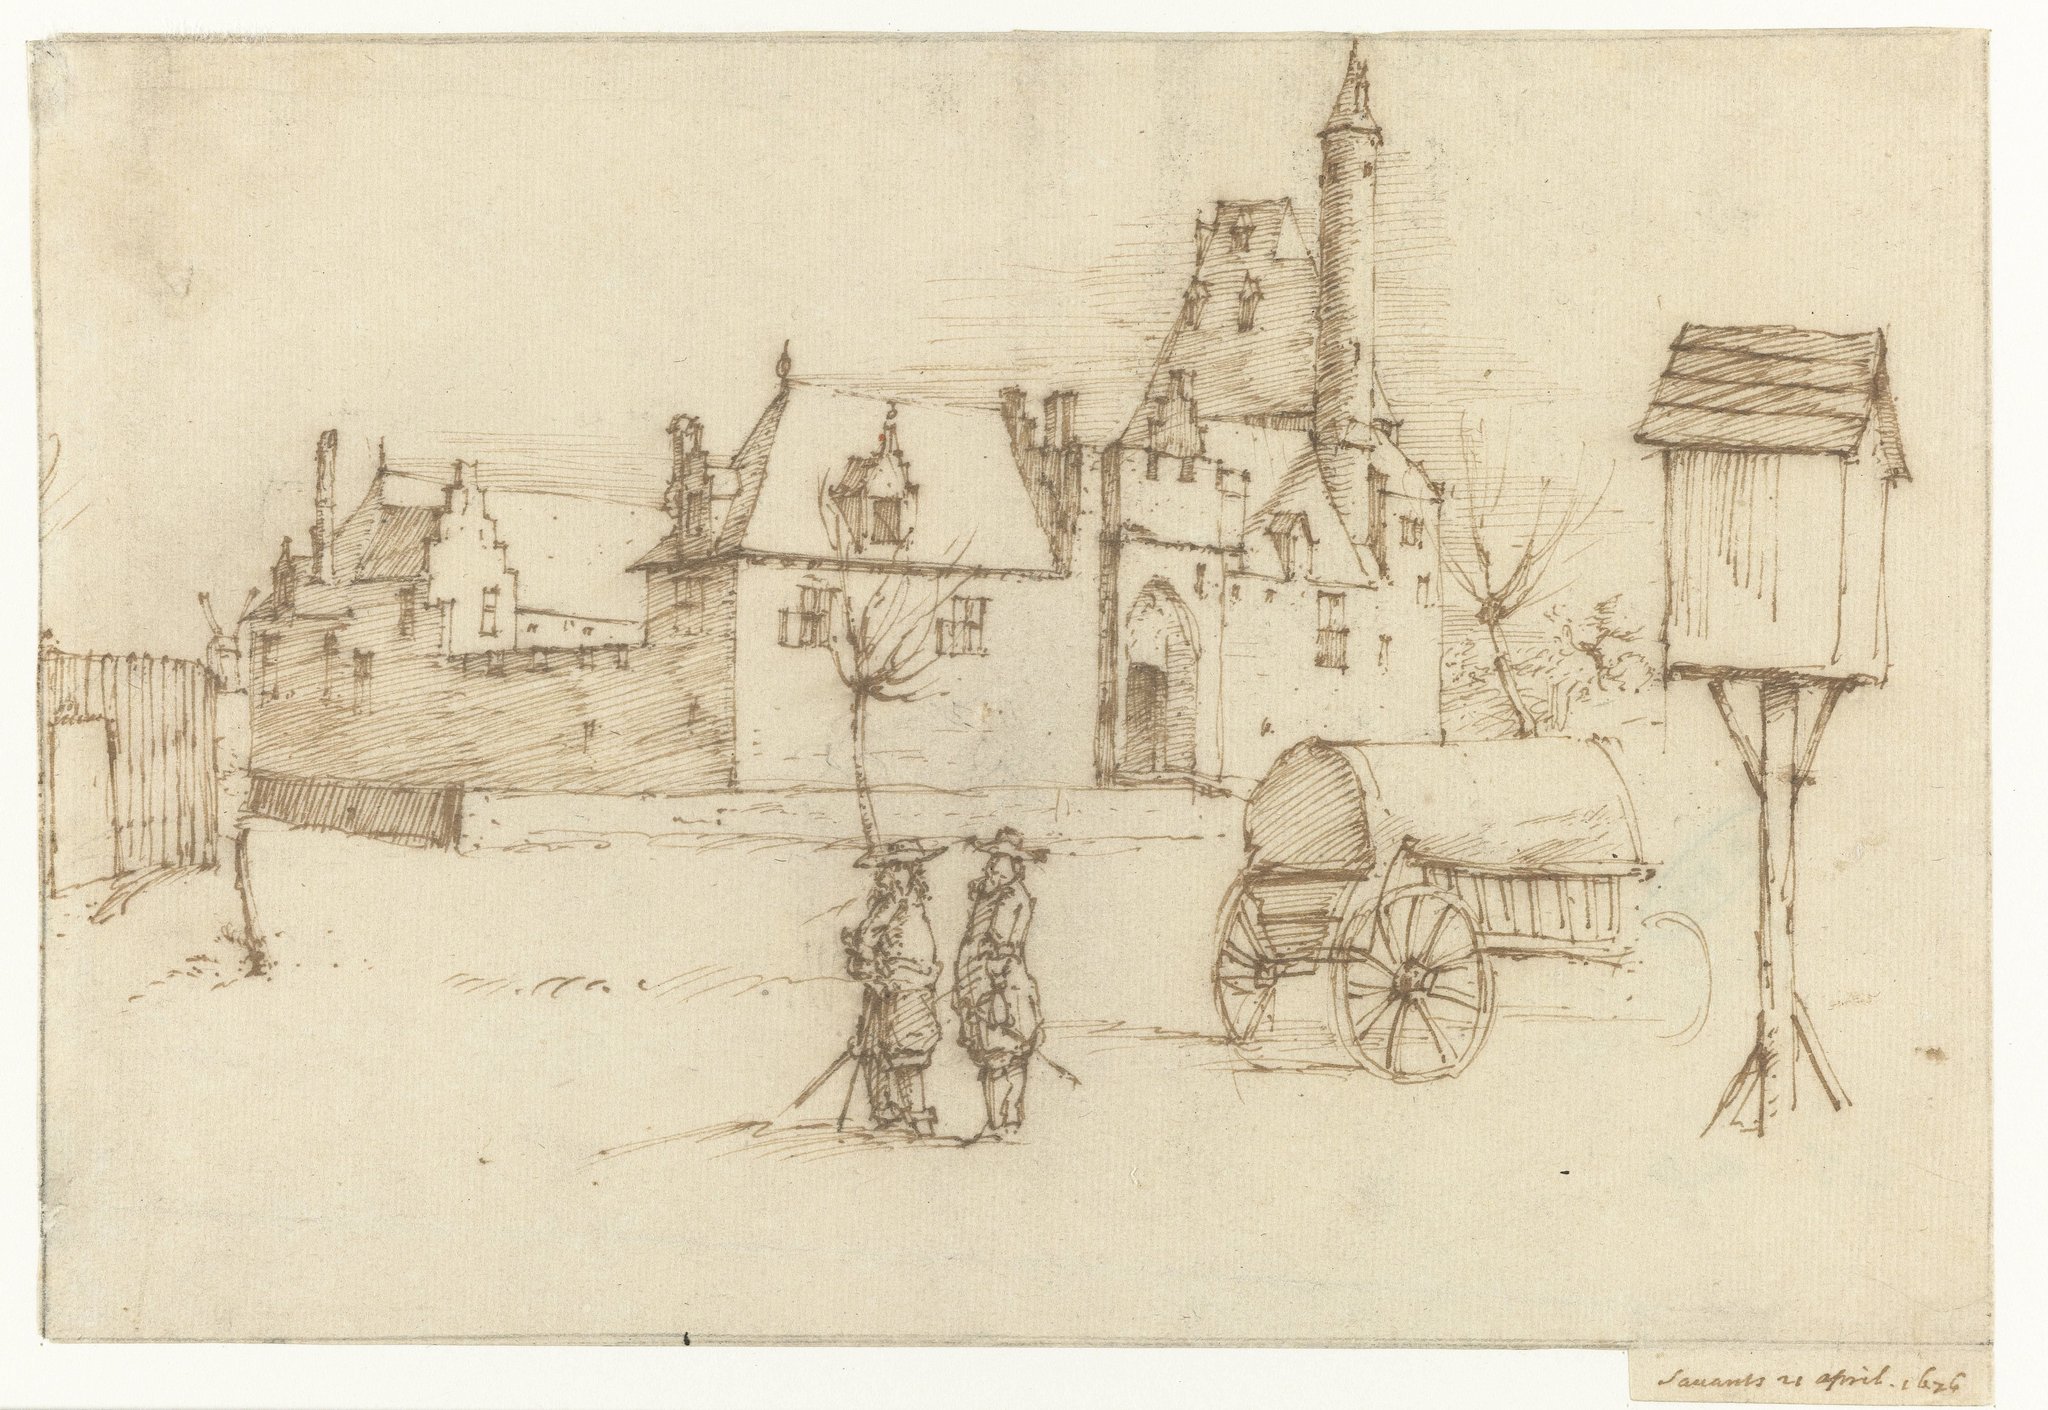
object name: drawing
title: Zemst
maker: constantijn huygens (ii)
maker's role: draughtsman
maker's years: 1628-1697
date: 1676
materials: ink, paper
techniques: pen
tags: castle